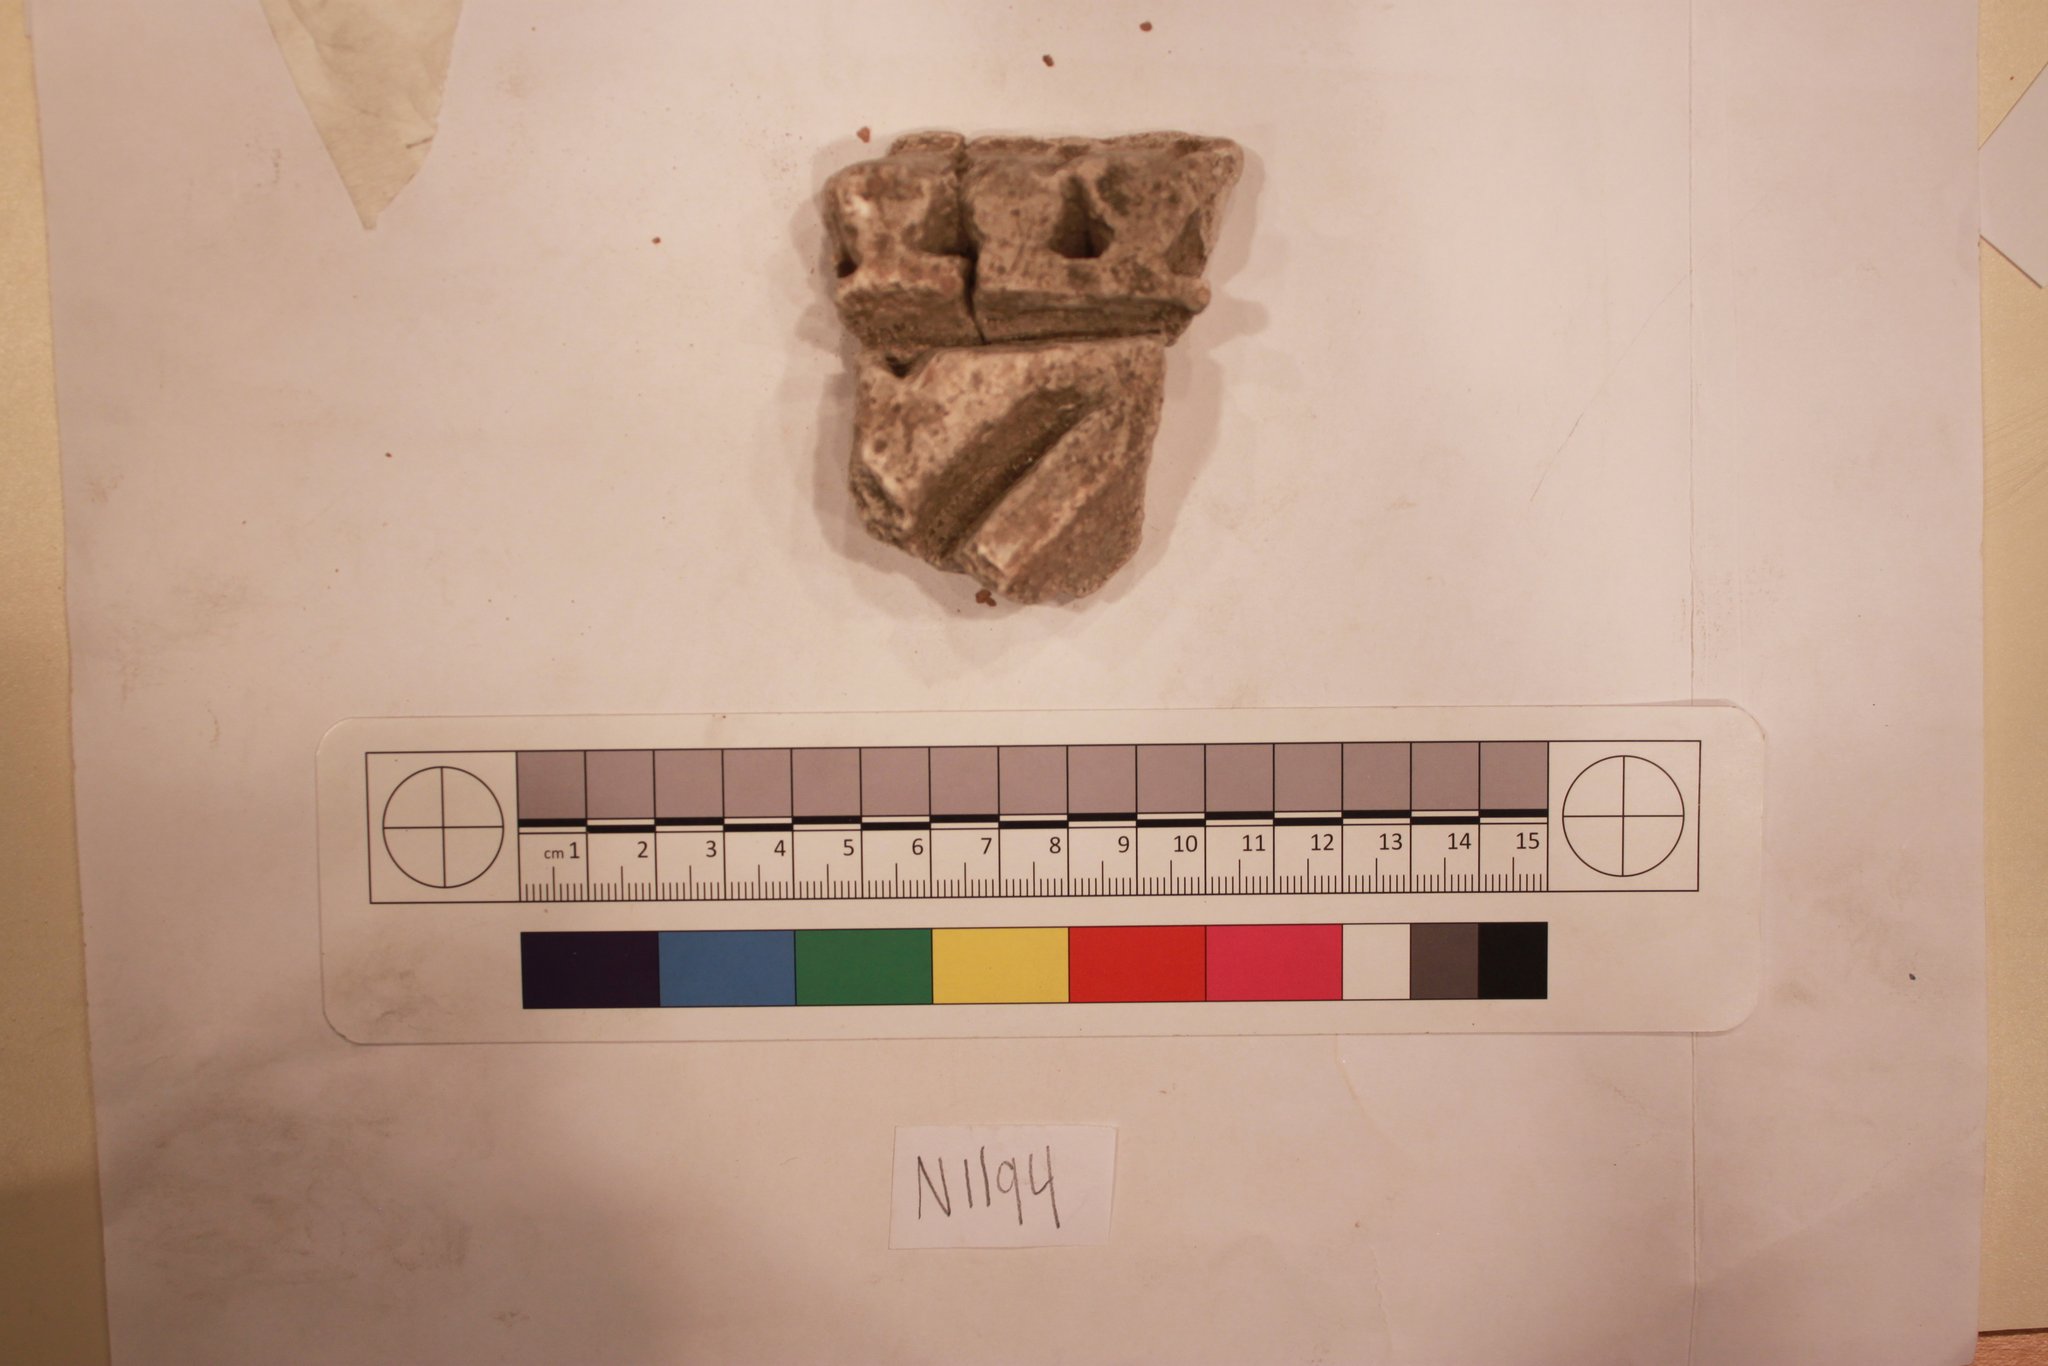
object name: fragment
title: Stucco Fragment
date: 701-1200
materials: plaster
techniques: carving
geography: iran